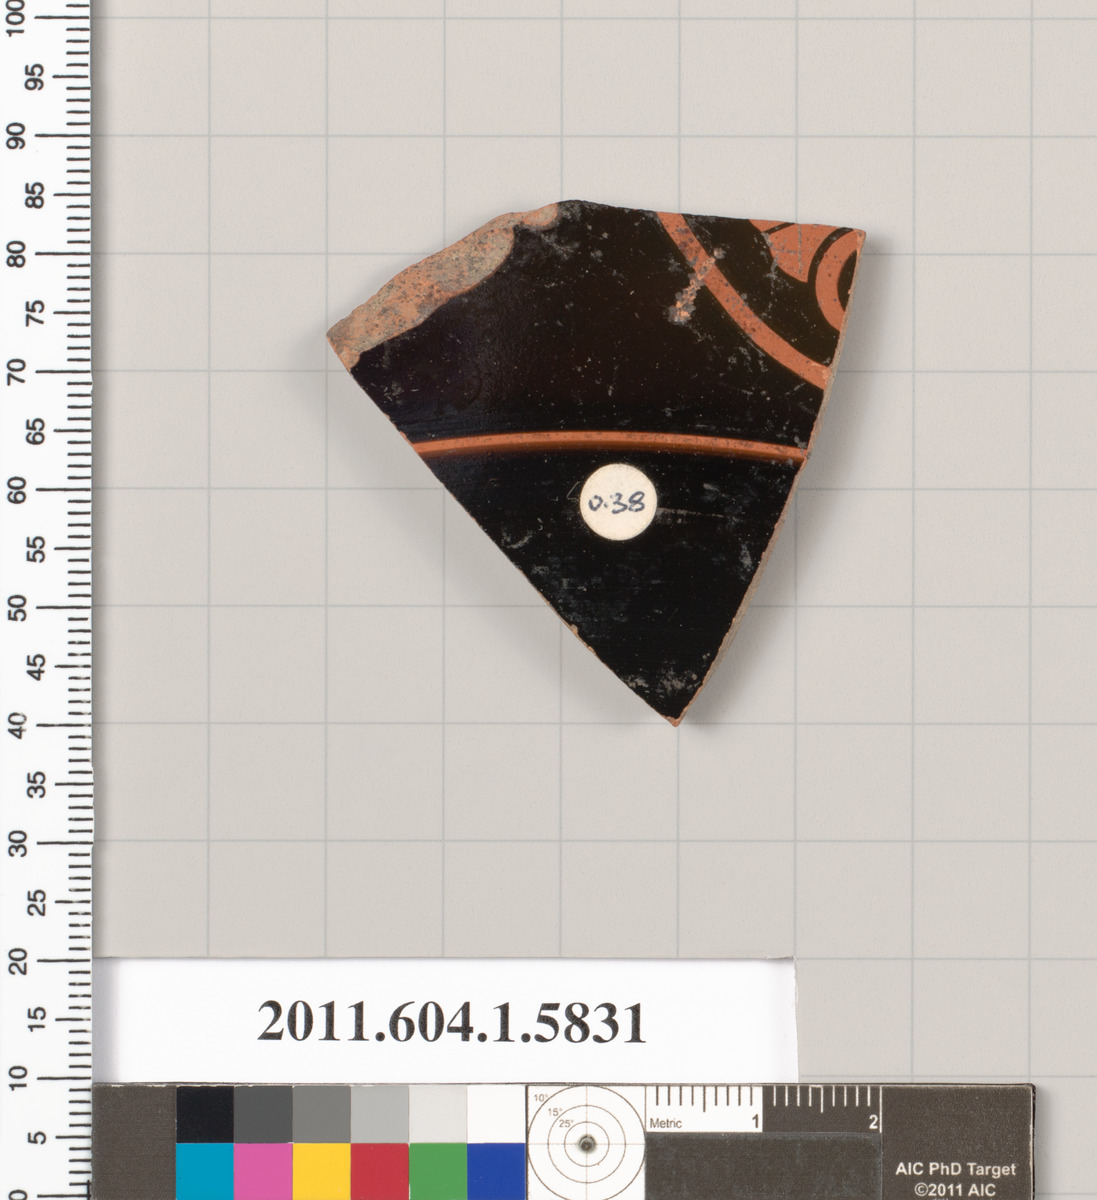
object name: kylix fragment, eye cup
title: Terracotta fragment of a kylix: eye-cup (drinking cup)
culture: greek, attic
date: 520-510 BCE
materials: terracotta